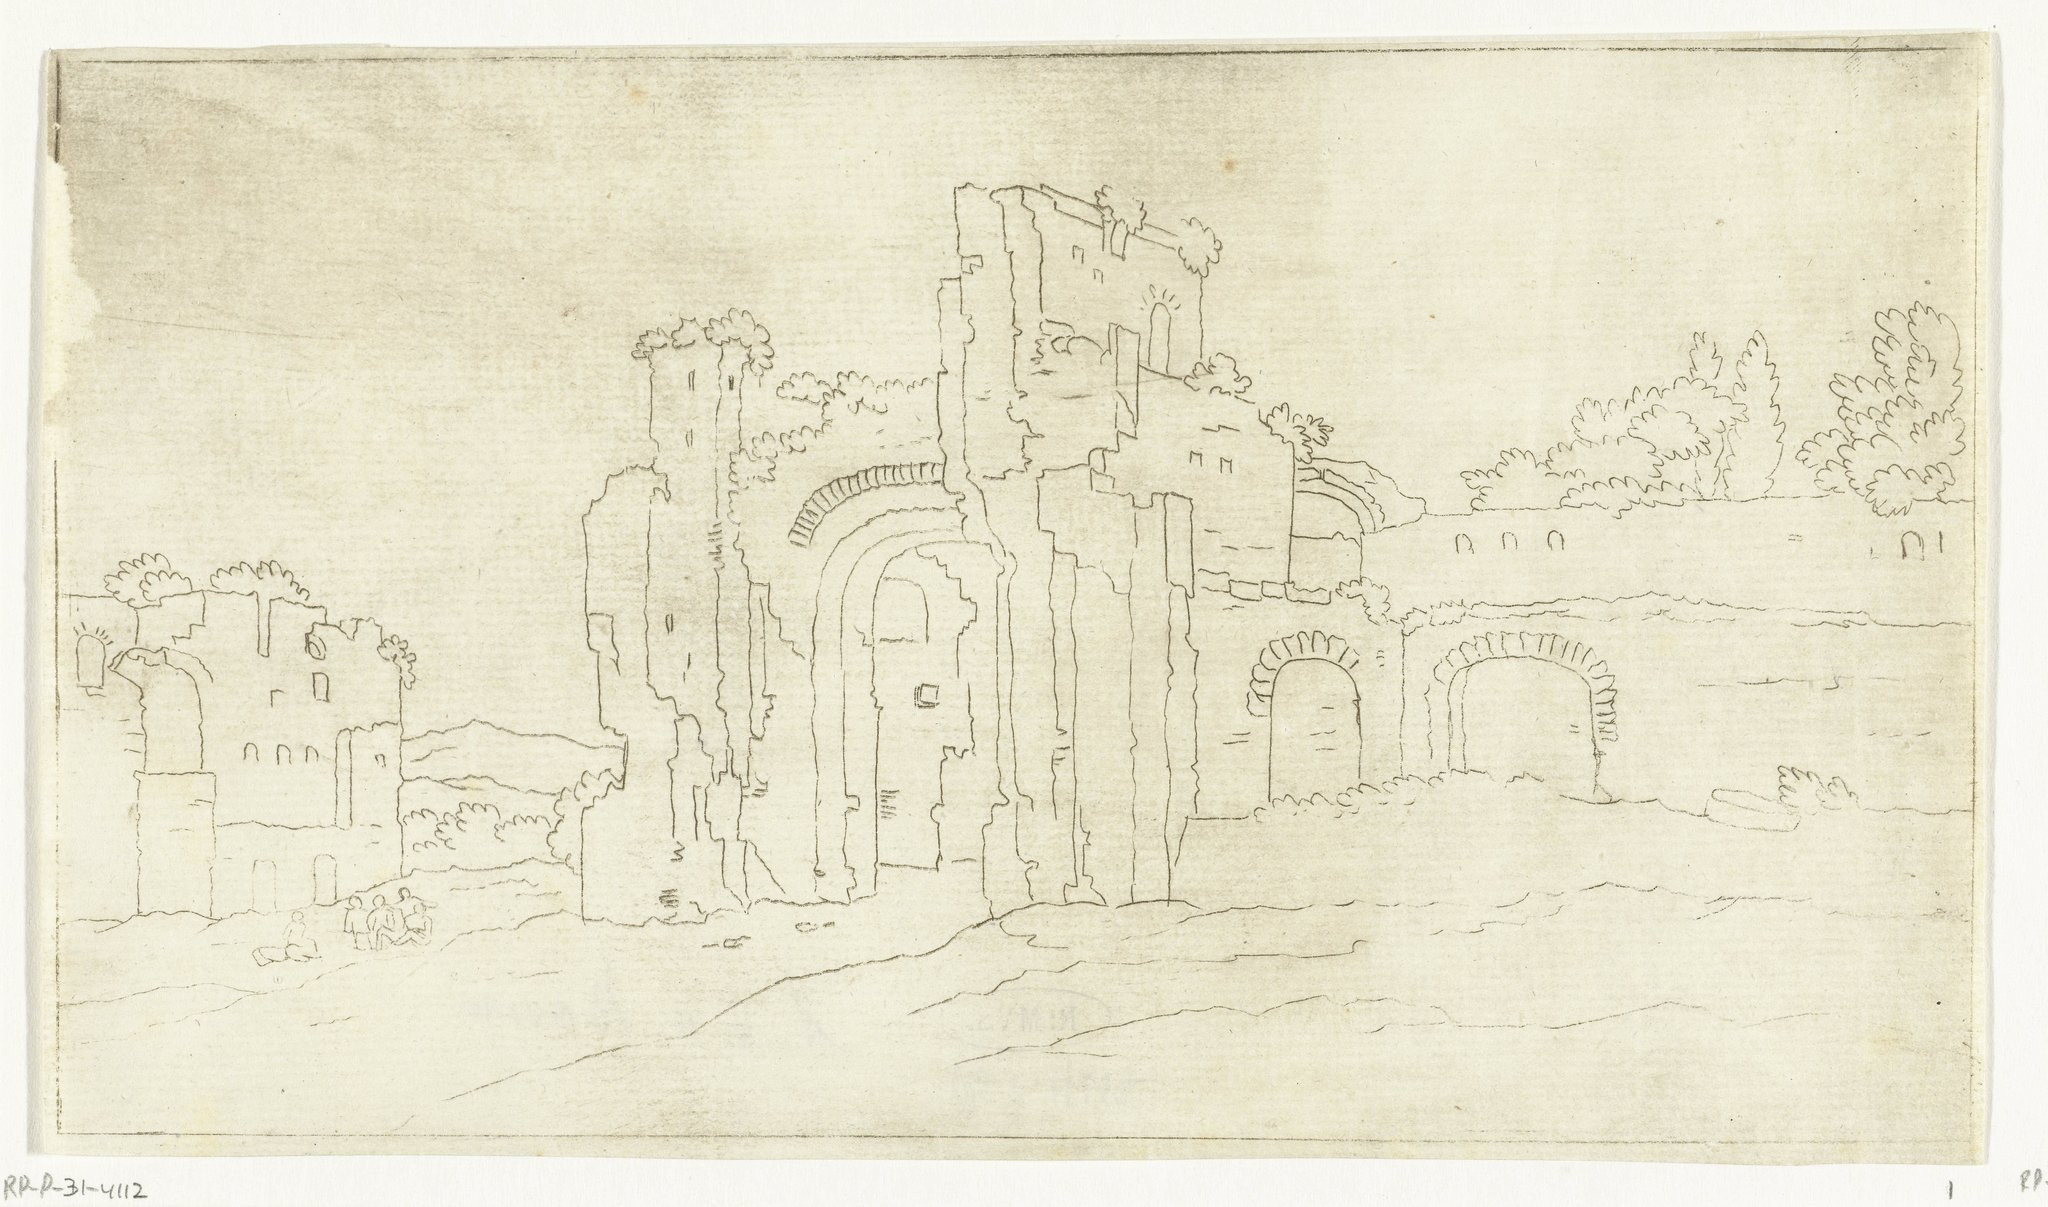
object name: print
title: Ruïnes van de grote zaal van de Thermen van Caracalla, Rome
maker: anthonie van den bos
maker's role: draughtsman, print maker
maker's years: 1763-1838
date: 1778-1838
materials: paper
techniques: etching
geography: netherlands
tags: landscape with ruins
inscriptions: collector's mark: Lugt 2228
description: Naar een tekening in Parijs, Fondation Custodia (coll. F. Lugt), Parijs, inv.nr. 6481, fol. 33, met het opschrift 'Therme Antonini' (de Thermen van Caracalla worden in het Latijn 'Thermae Antoninianae' genoemd).